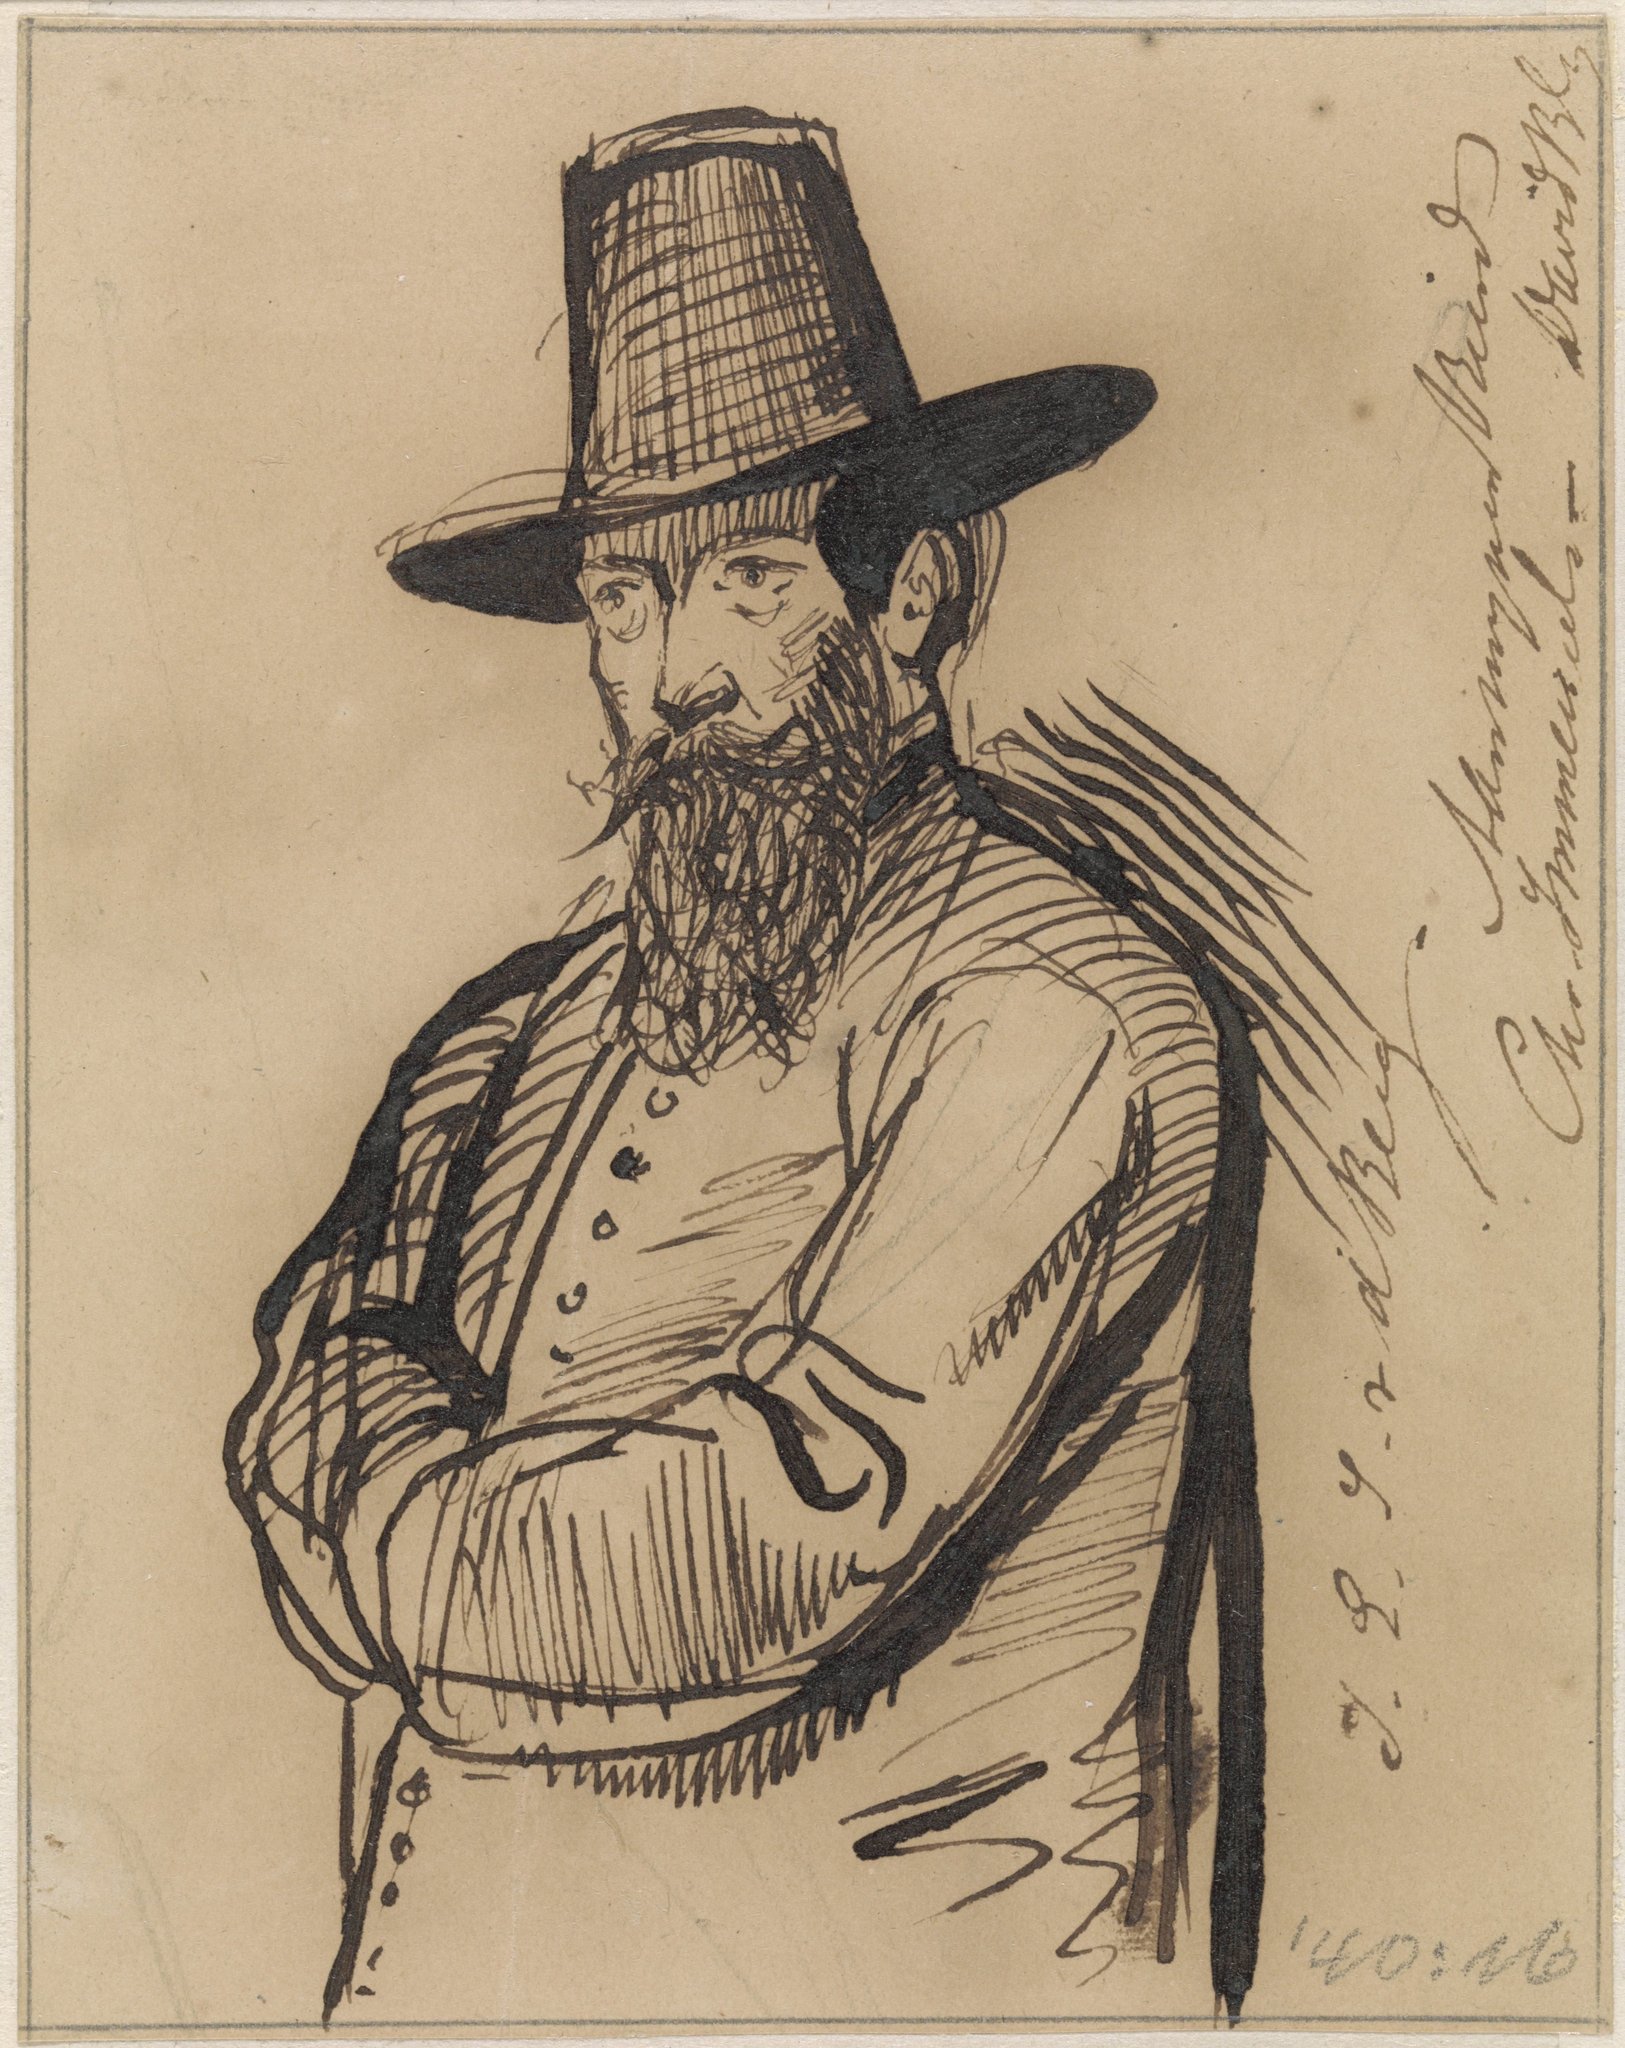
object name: drawing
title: Portret van Jacobus Everardus Josephus van den Berg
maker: david bles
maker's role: draughtsman, painter, print maker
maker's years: 1821-1899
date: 1840-1861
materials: ink, paper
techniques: pen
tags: rotterdam, the hague, draughtsman, jacobus everhardus josephus van den berg, historical persons, portrait, self-portrait of painter, portrait, self-portrait of artist, portrait, self-portrait of draughtsman